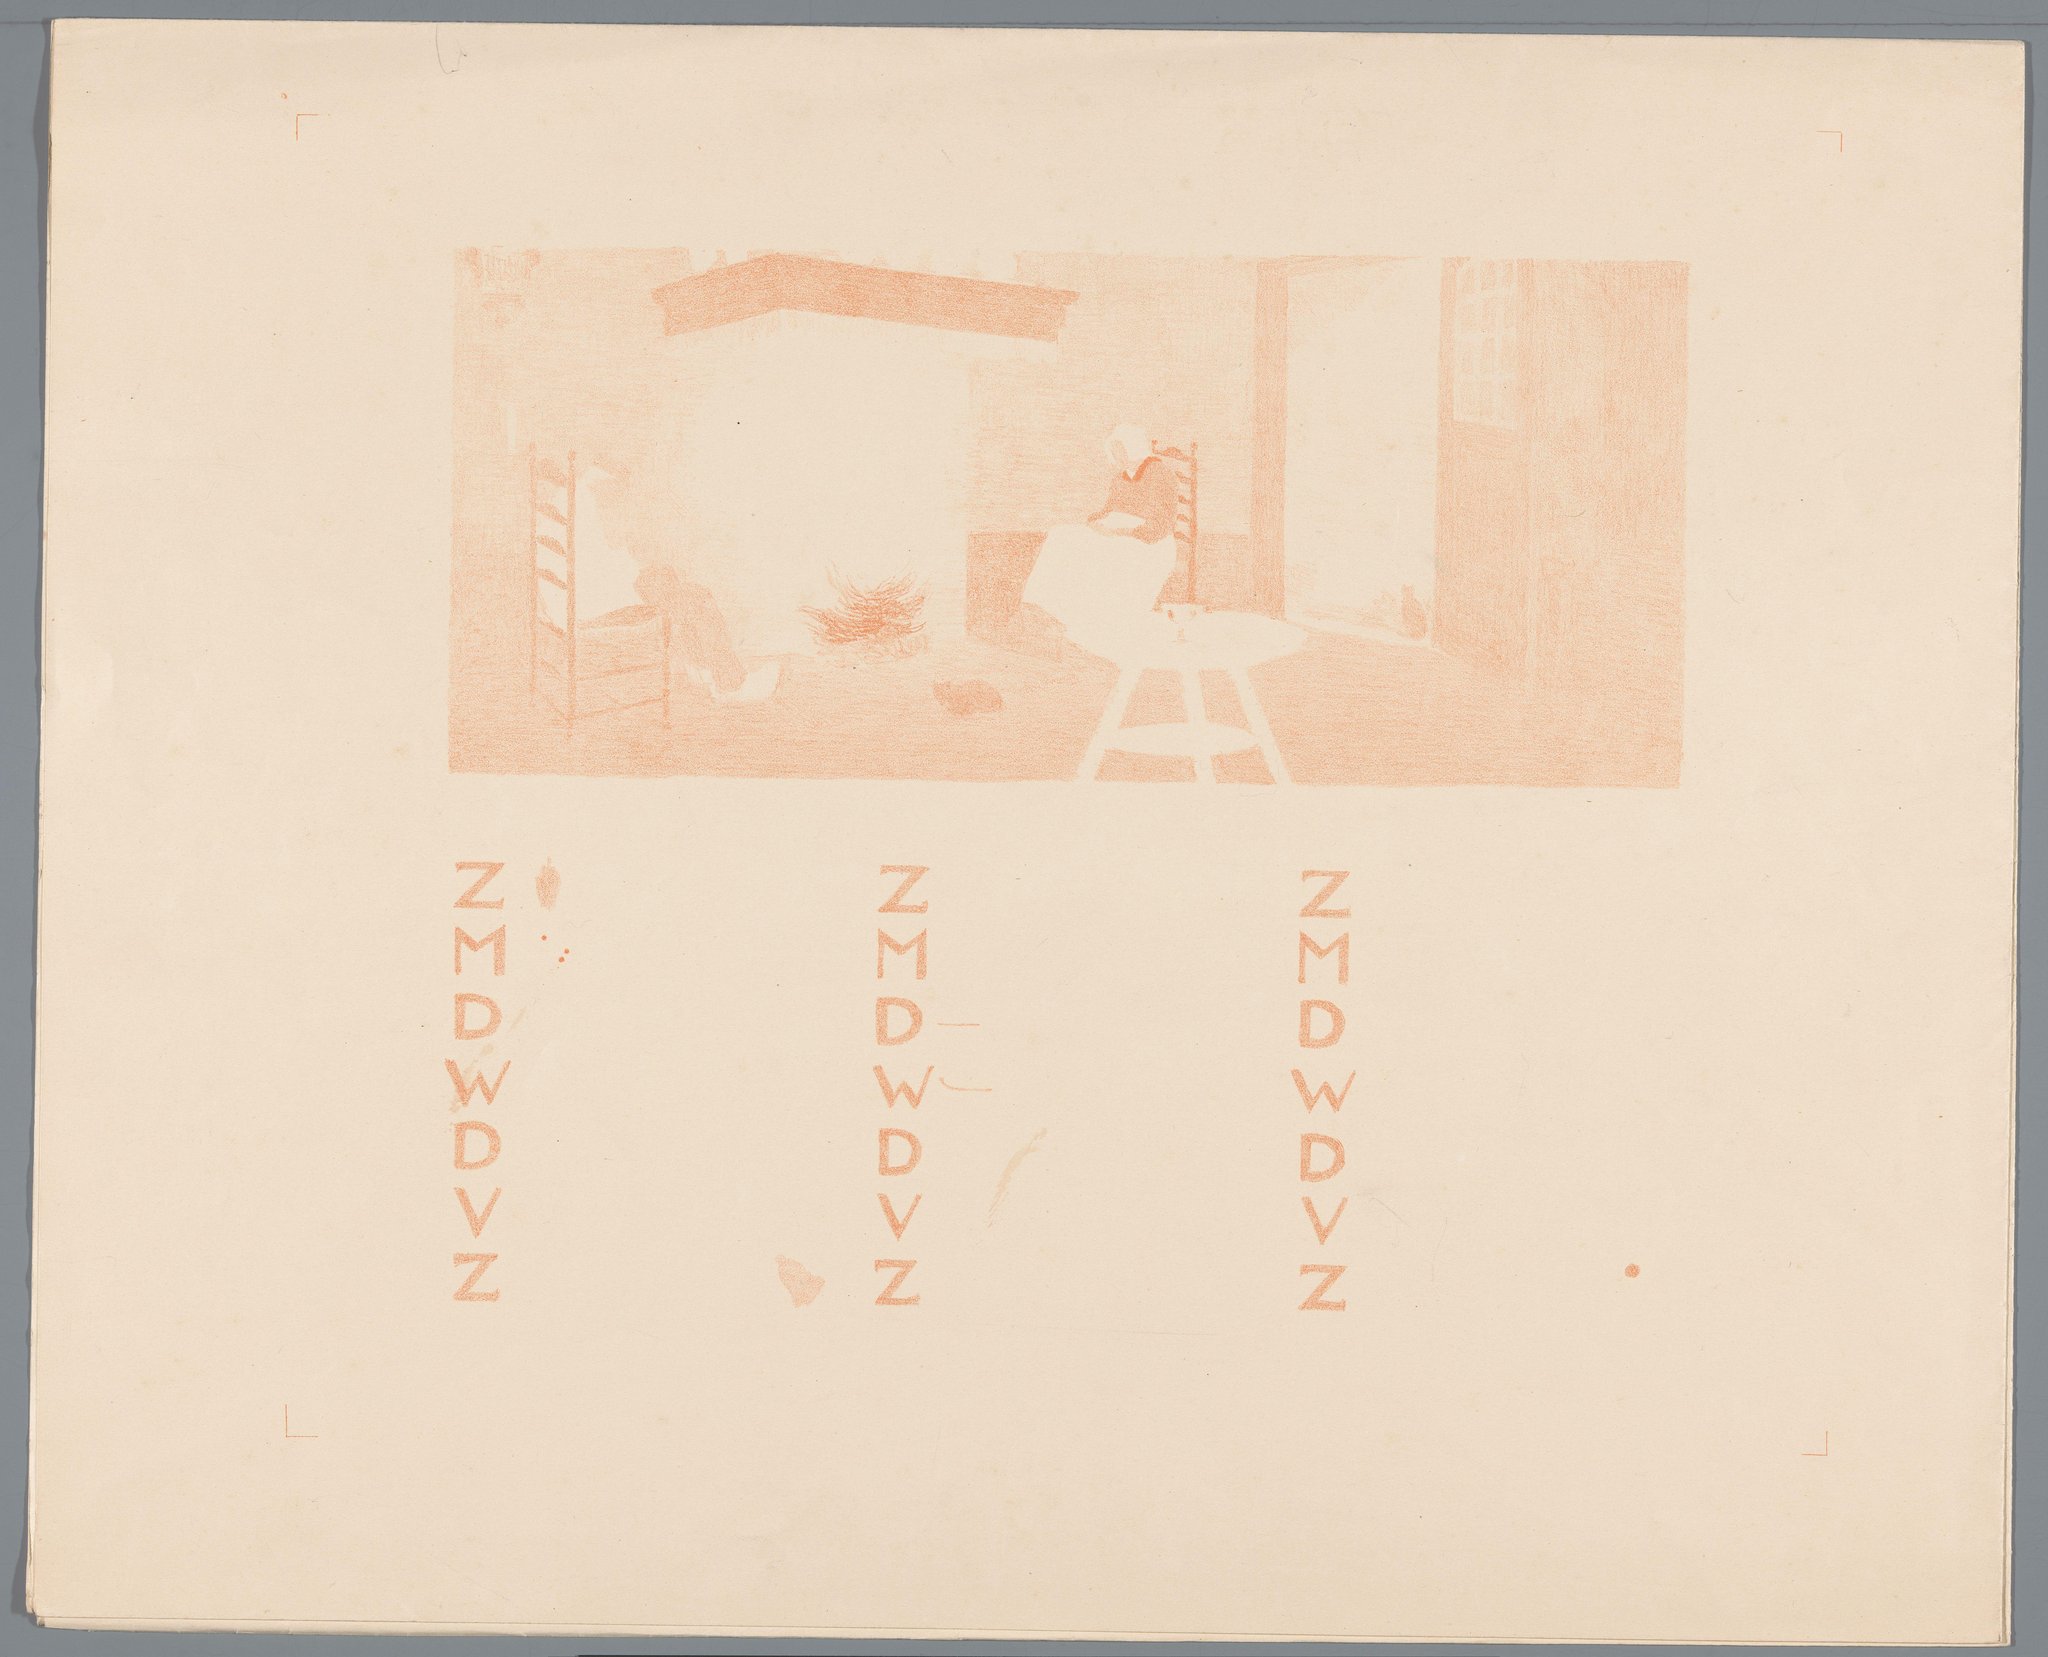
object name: print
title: Kalender voor 1903-1904 van de Verzekering-Maatschappij Holda in Amsterdam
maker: ferdinand hart nibbrig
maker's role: draughtsman, painter, print maker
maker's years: 1866-1915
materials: paper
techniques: lithograph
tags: the four seasons of the year ~ human activities, human life divided into stages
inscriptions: collector's mark: Lugt 2228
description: Linksboven een rechthoekig kader opgevuld met de dagen van de maanden september, oktober en november en daarboven een boer en boerin, die samen een mand met appels dragen. Rechts van hen een jongen die staand op een ladder appels oogst. Rechtsboven een rechthoekig kader opgevuld met de dagen van de maanden december, januari en februari en daarboven een boer en boerin, zittend bij een haardvuur met één van hun katten. In de deuropening nog een kat, die naar twee mannen kijkt die in een stal aan het werk zijn. Linksonder een rechthoekig kader opgevuld met de dagen van de maanden juni, juli en augustus en daarboven een man en een vrouw die een meisje leren lopen. Links een waterpomp bij een boerderij. Rechts zonnebloemen. Rechtsonder een rechthoekig kader opgevuld met de dagen van de maanden maart, april en mei en daarboven twee knielende jongens die een geit voeren in een boomgaard. Op de achtergrond twee meisjes op klompen die bloemen plukken.